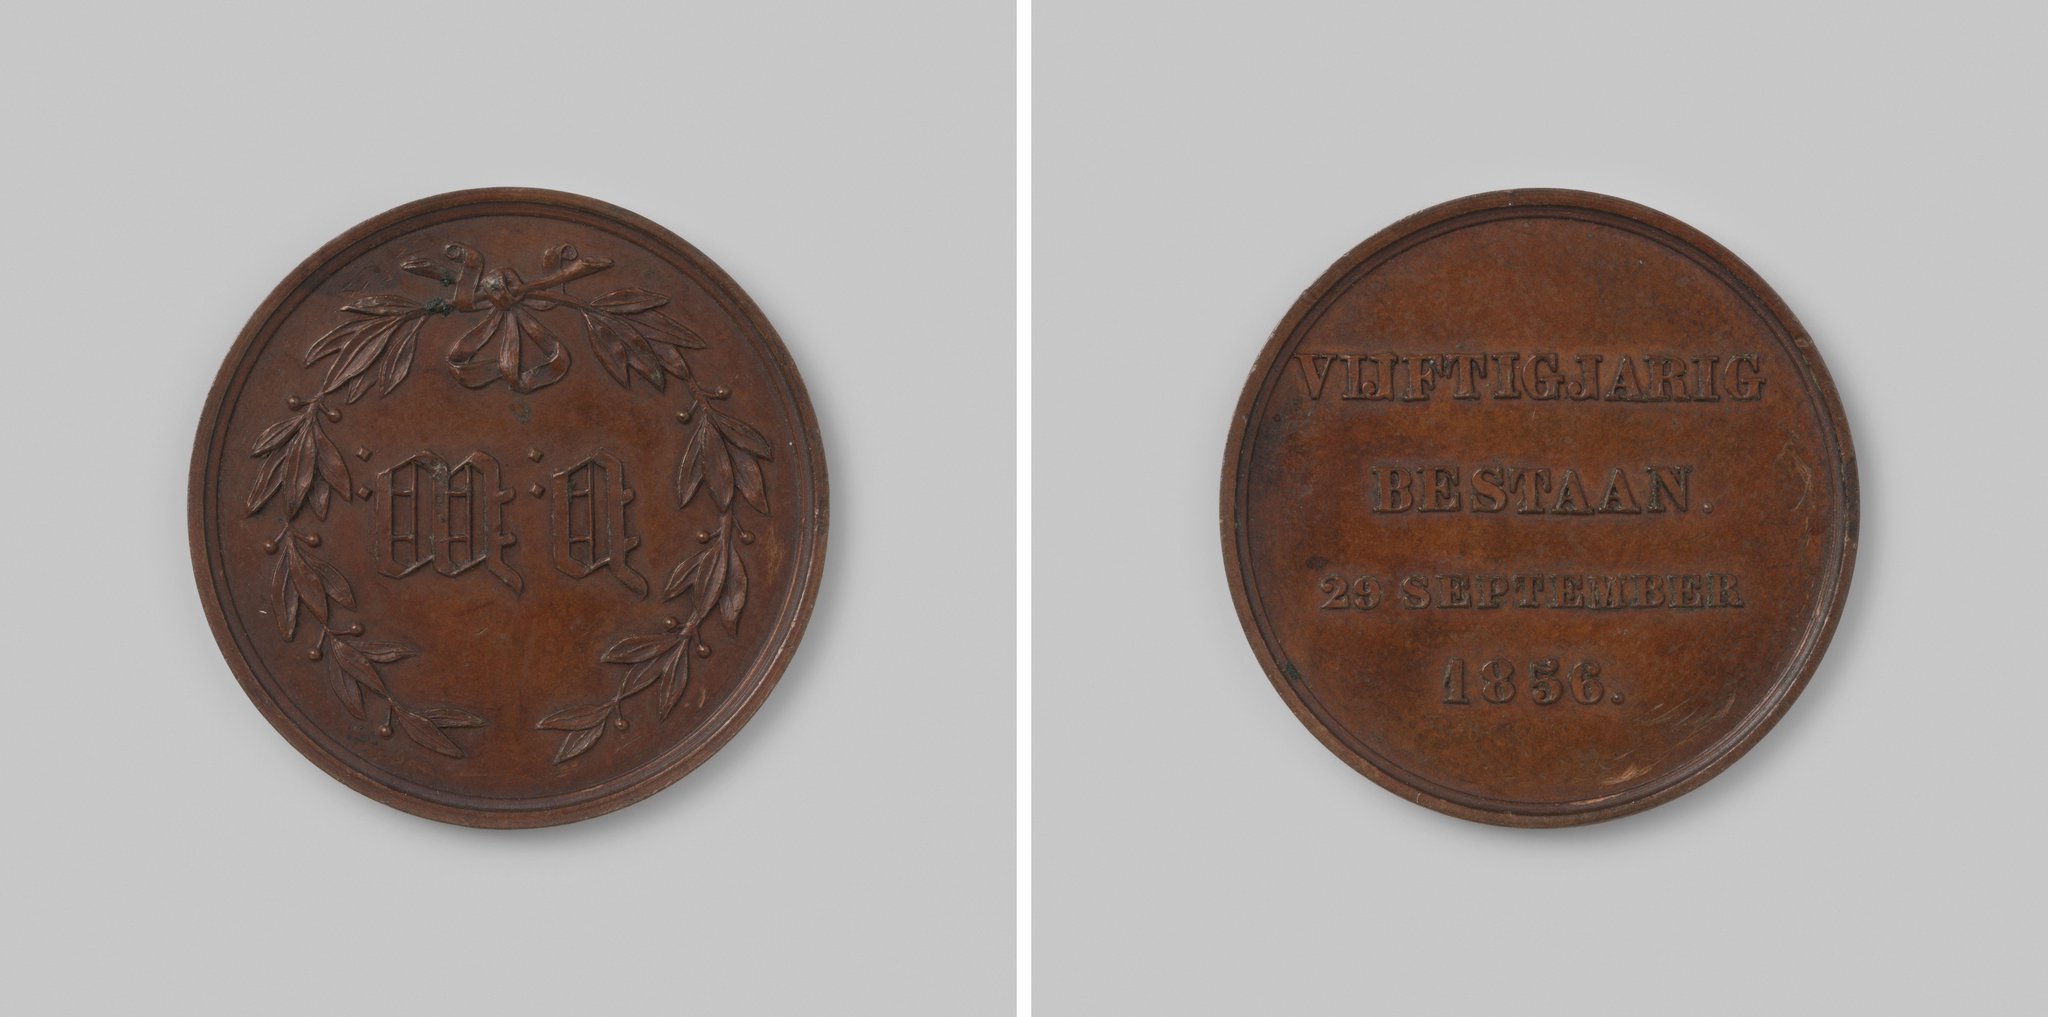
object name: history medal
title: Vijftigjarig bestaan van het Letterkundig Gezelschap V.W. te Amsterdam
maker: david van der kellen (1804-1879)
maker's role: die cutter, draughtsman, print maker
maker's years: 1804-1879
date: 1856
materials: bronze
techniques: striking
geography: utrecht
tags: amsterdam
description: Bronzen penning. Voorzijde: letters V en W in Gothisch schrift binnen lauwerkrans. Keerzijde: opschrift.